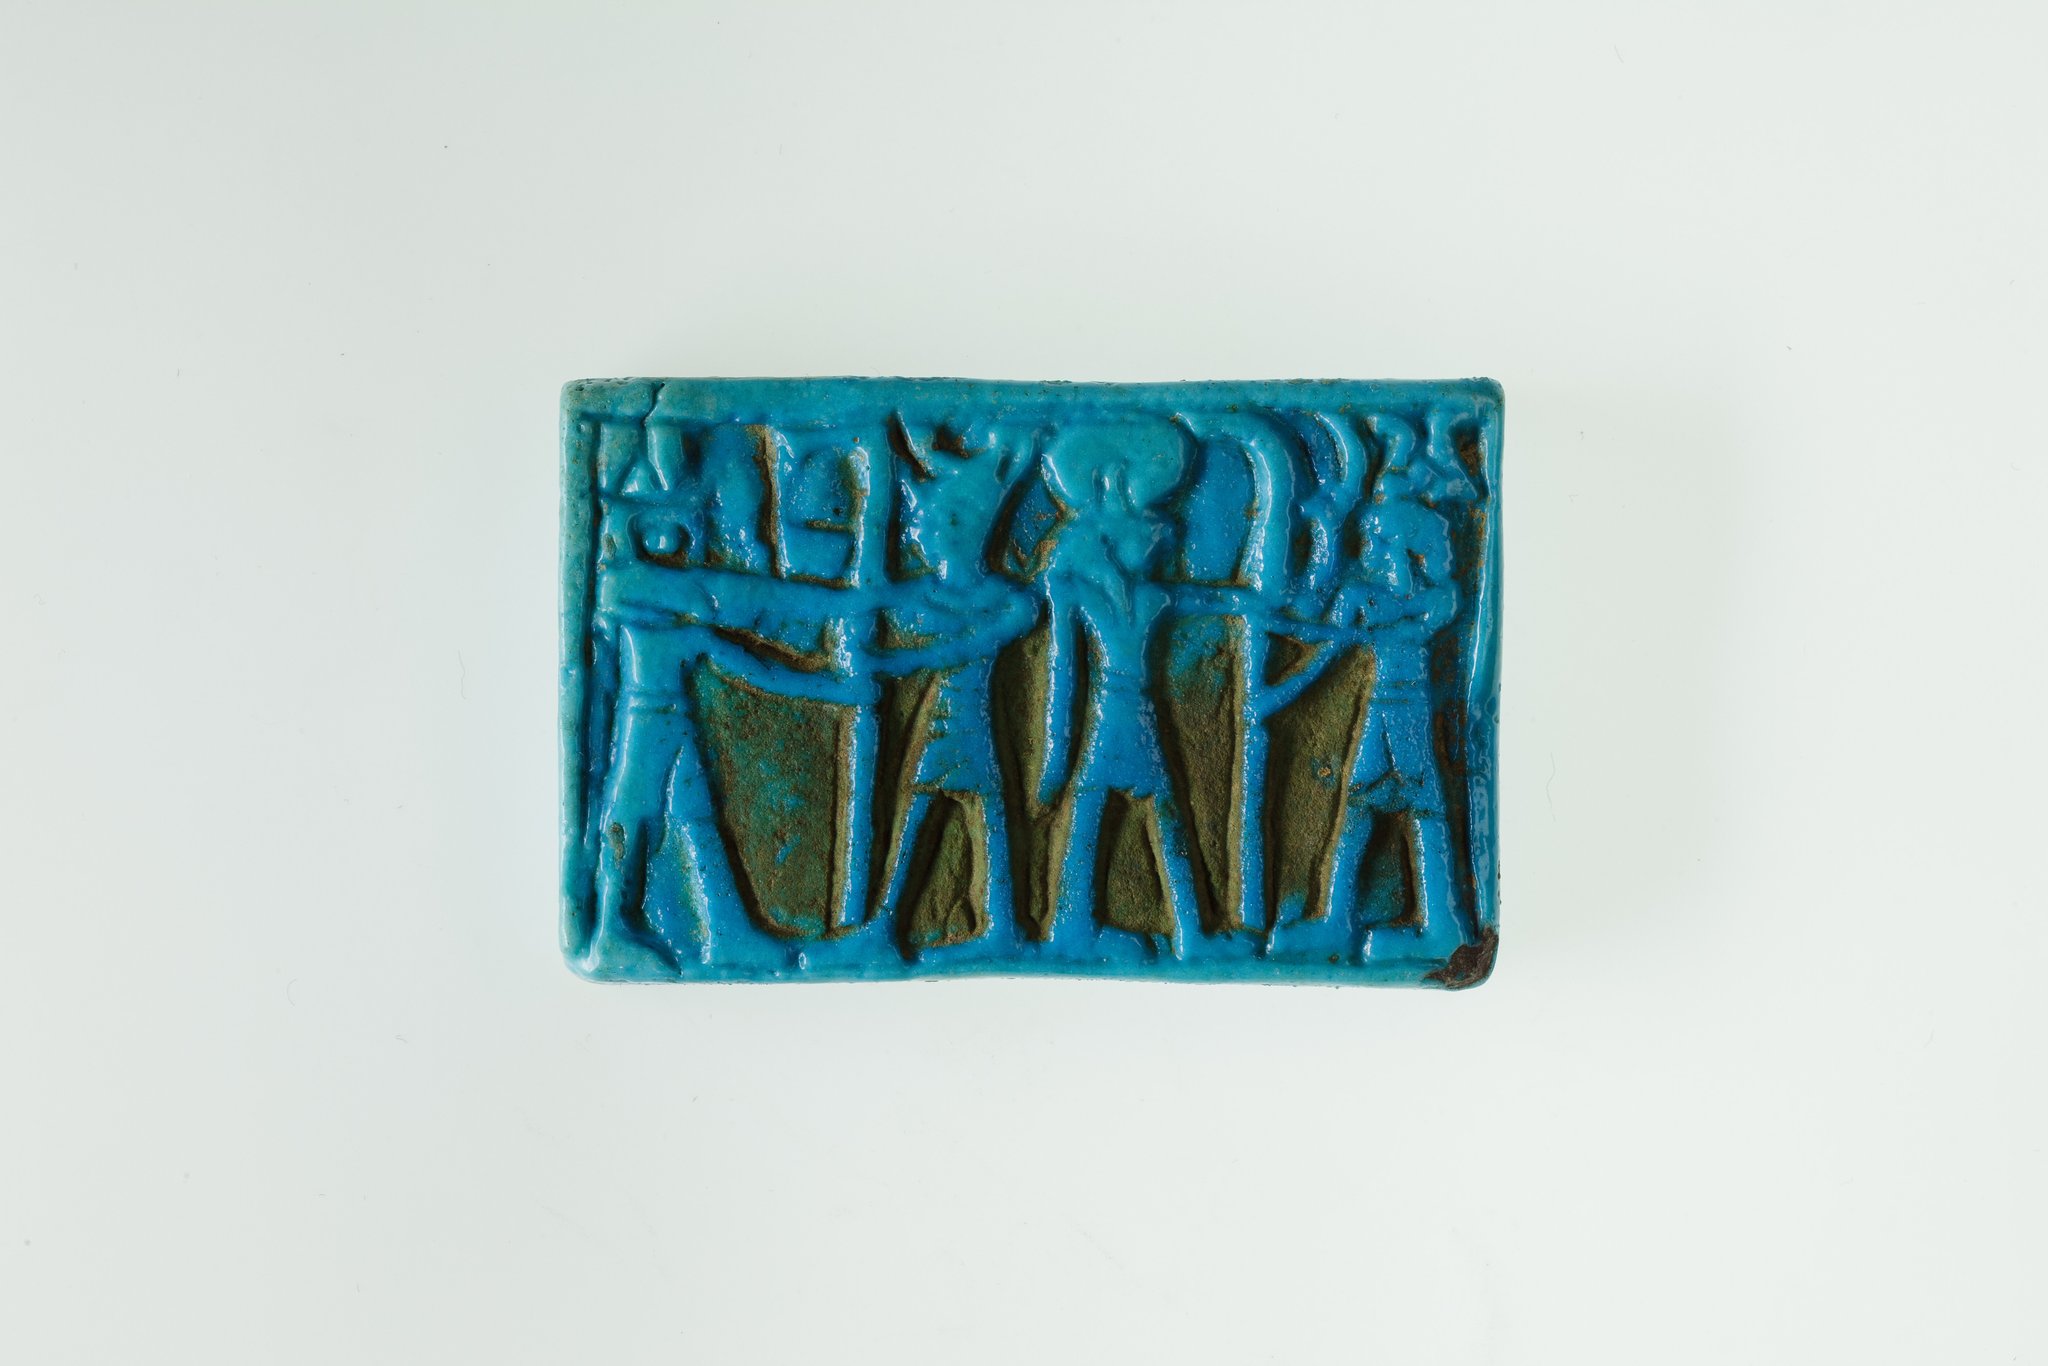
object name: bead, spacer, atum, raharakhty, winged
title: Spacer-bead with images of divinities and a king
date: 1070-715 BCE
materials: faience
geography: egypt